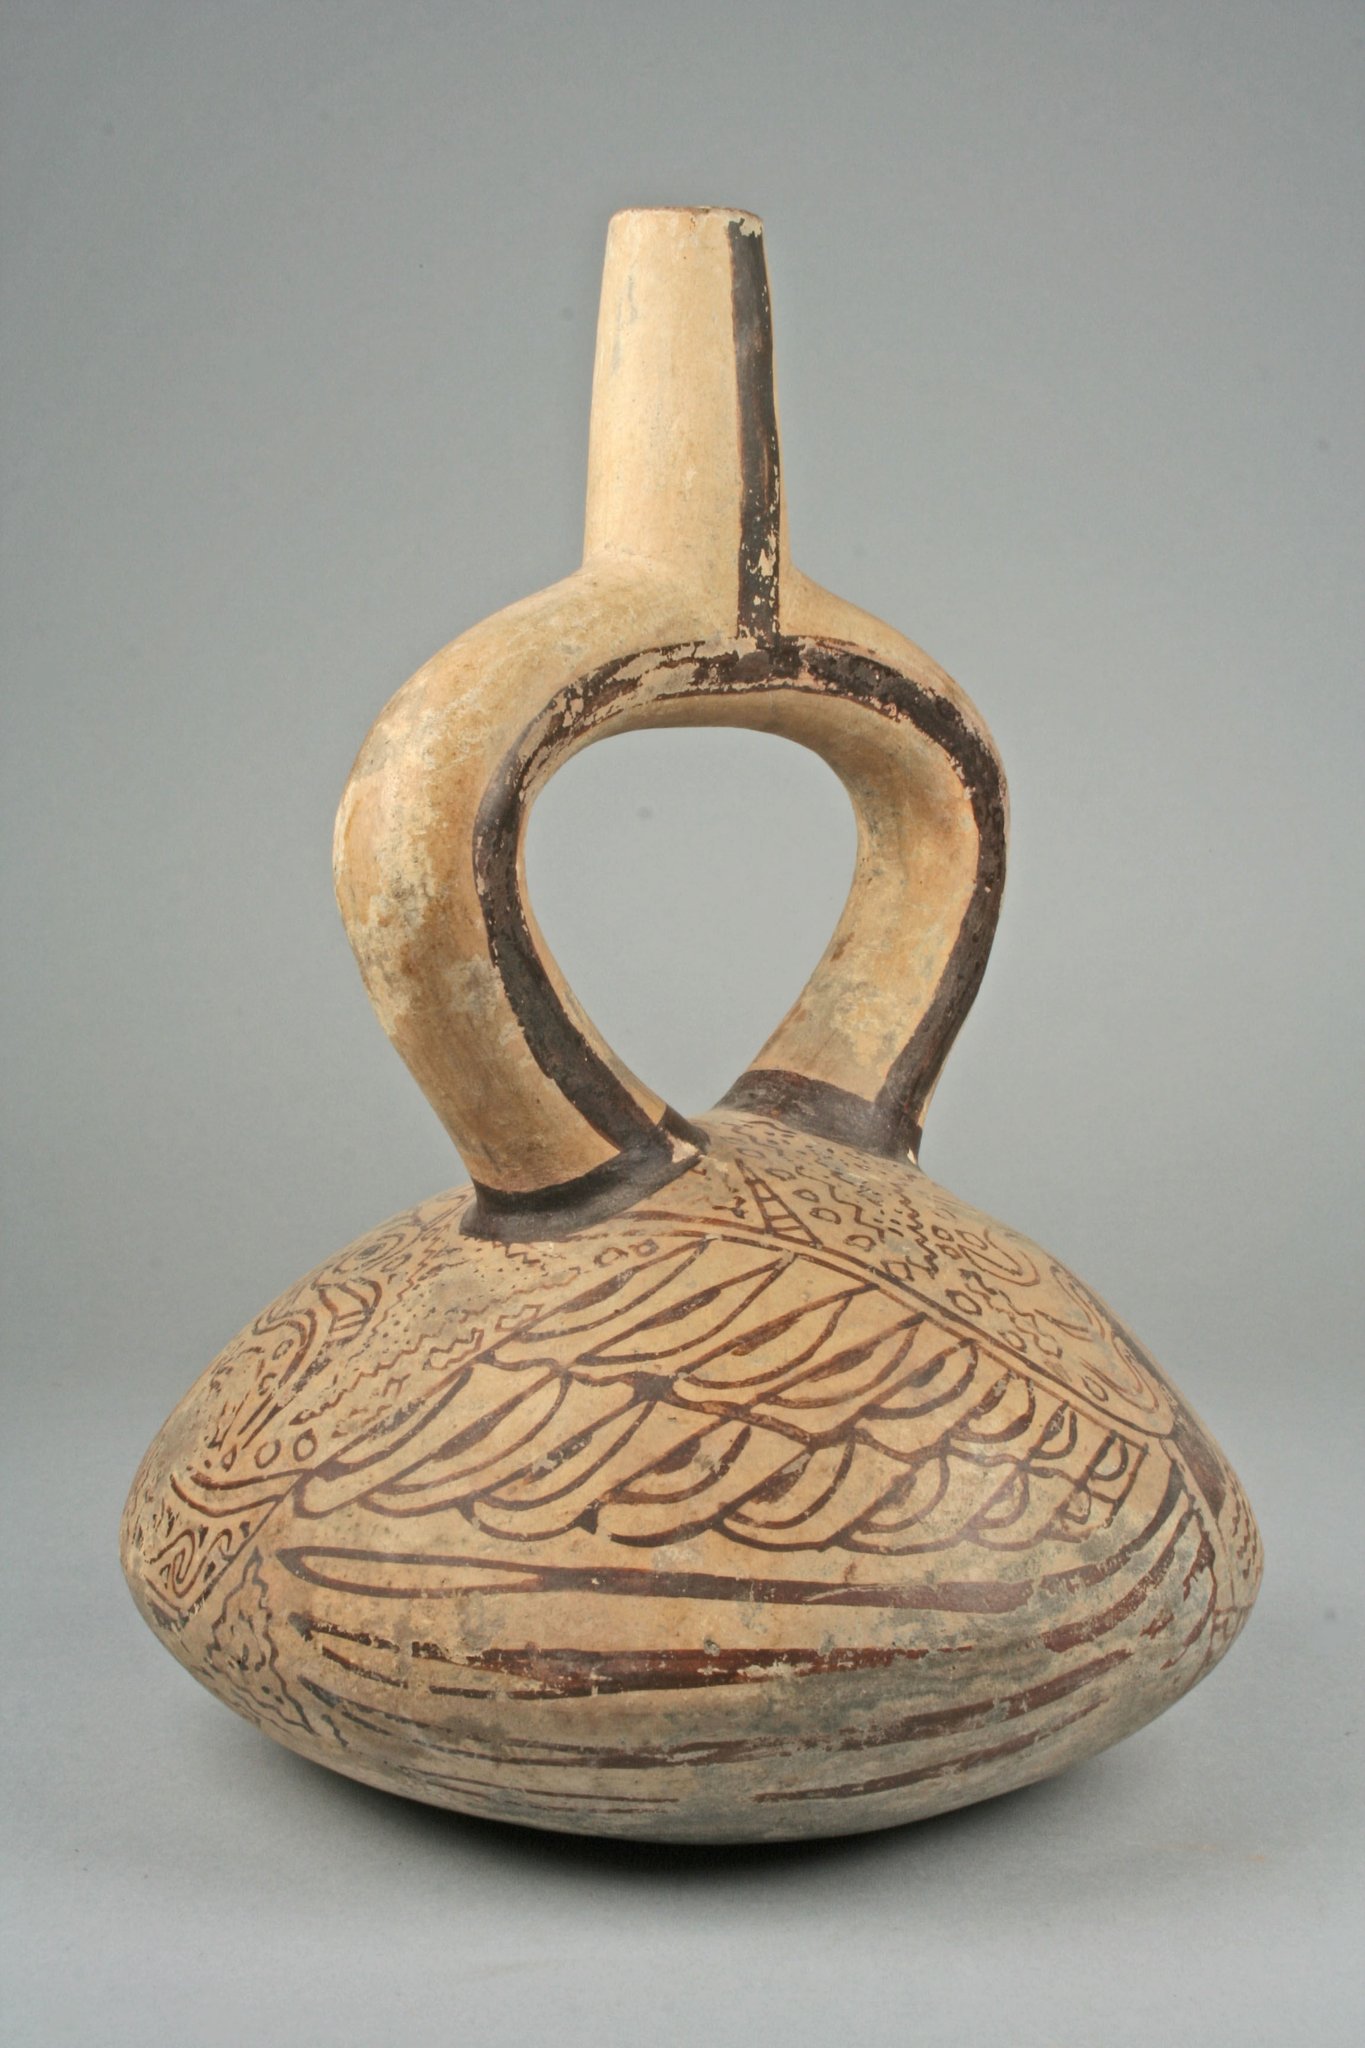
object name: bottle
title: Stirrup Spout Bottle with Birds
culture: moche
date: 501-700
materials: ceramic, pigment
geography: peru